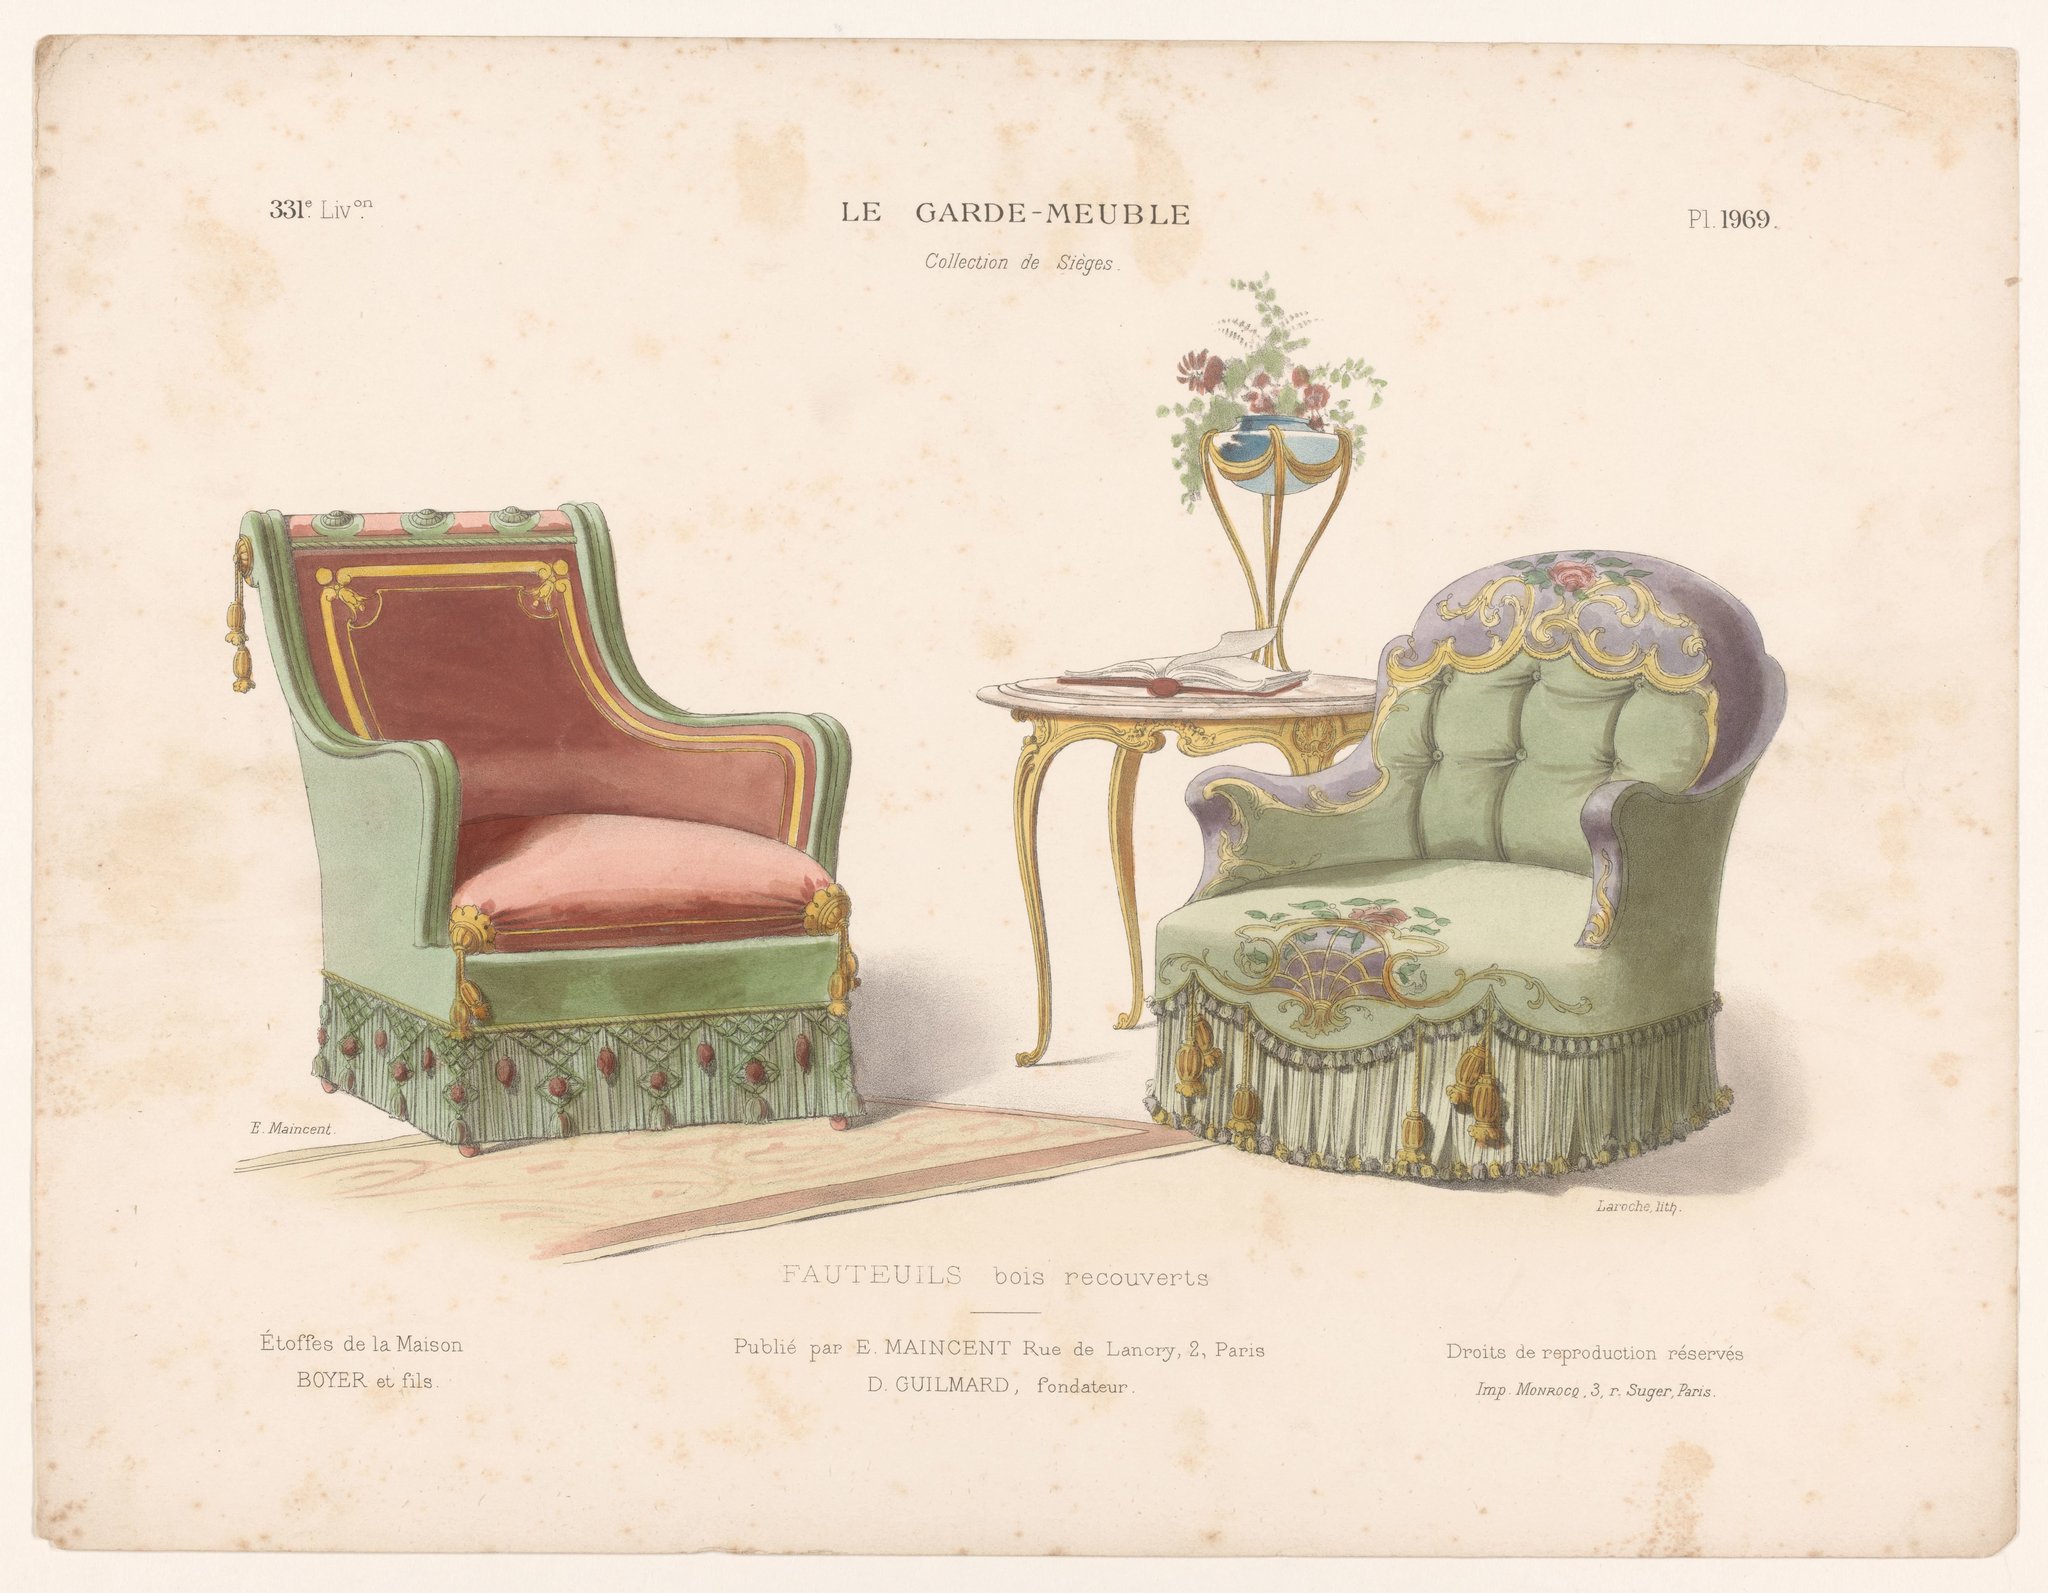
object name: print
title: Le garde-meuble / Collection de Sièges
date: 1885-1895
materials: paper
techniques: hand coloring, lithograph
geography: paris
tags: seating furniture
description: Ieder Livraison in de serie Le Garde-Meuble bevat negen platen: drie 'sièges' (zitmeubels), drie 'meubles' (diverse meubels zoals tafels en kasten) en drie 'tentures' (gordijnen en draperieën).